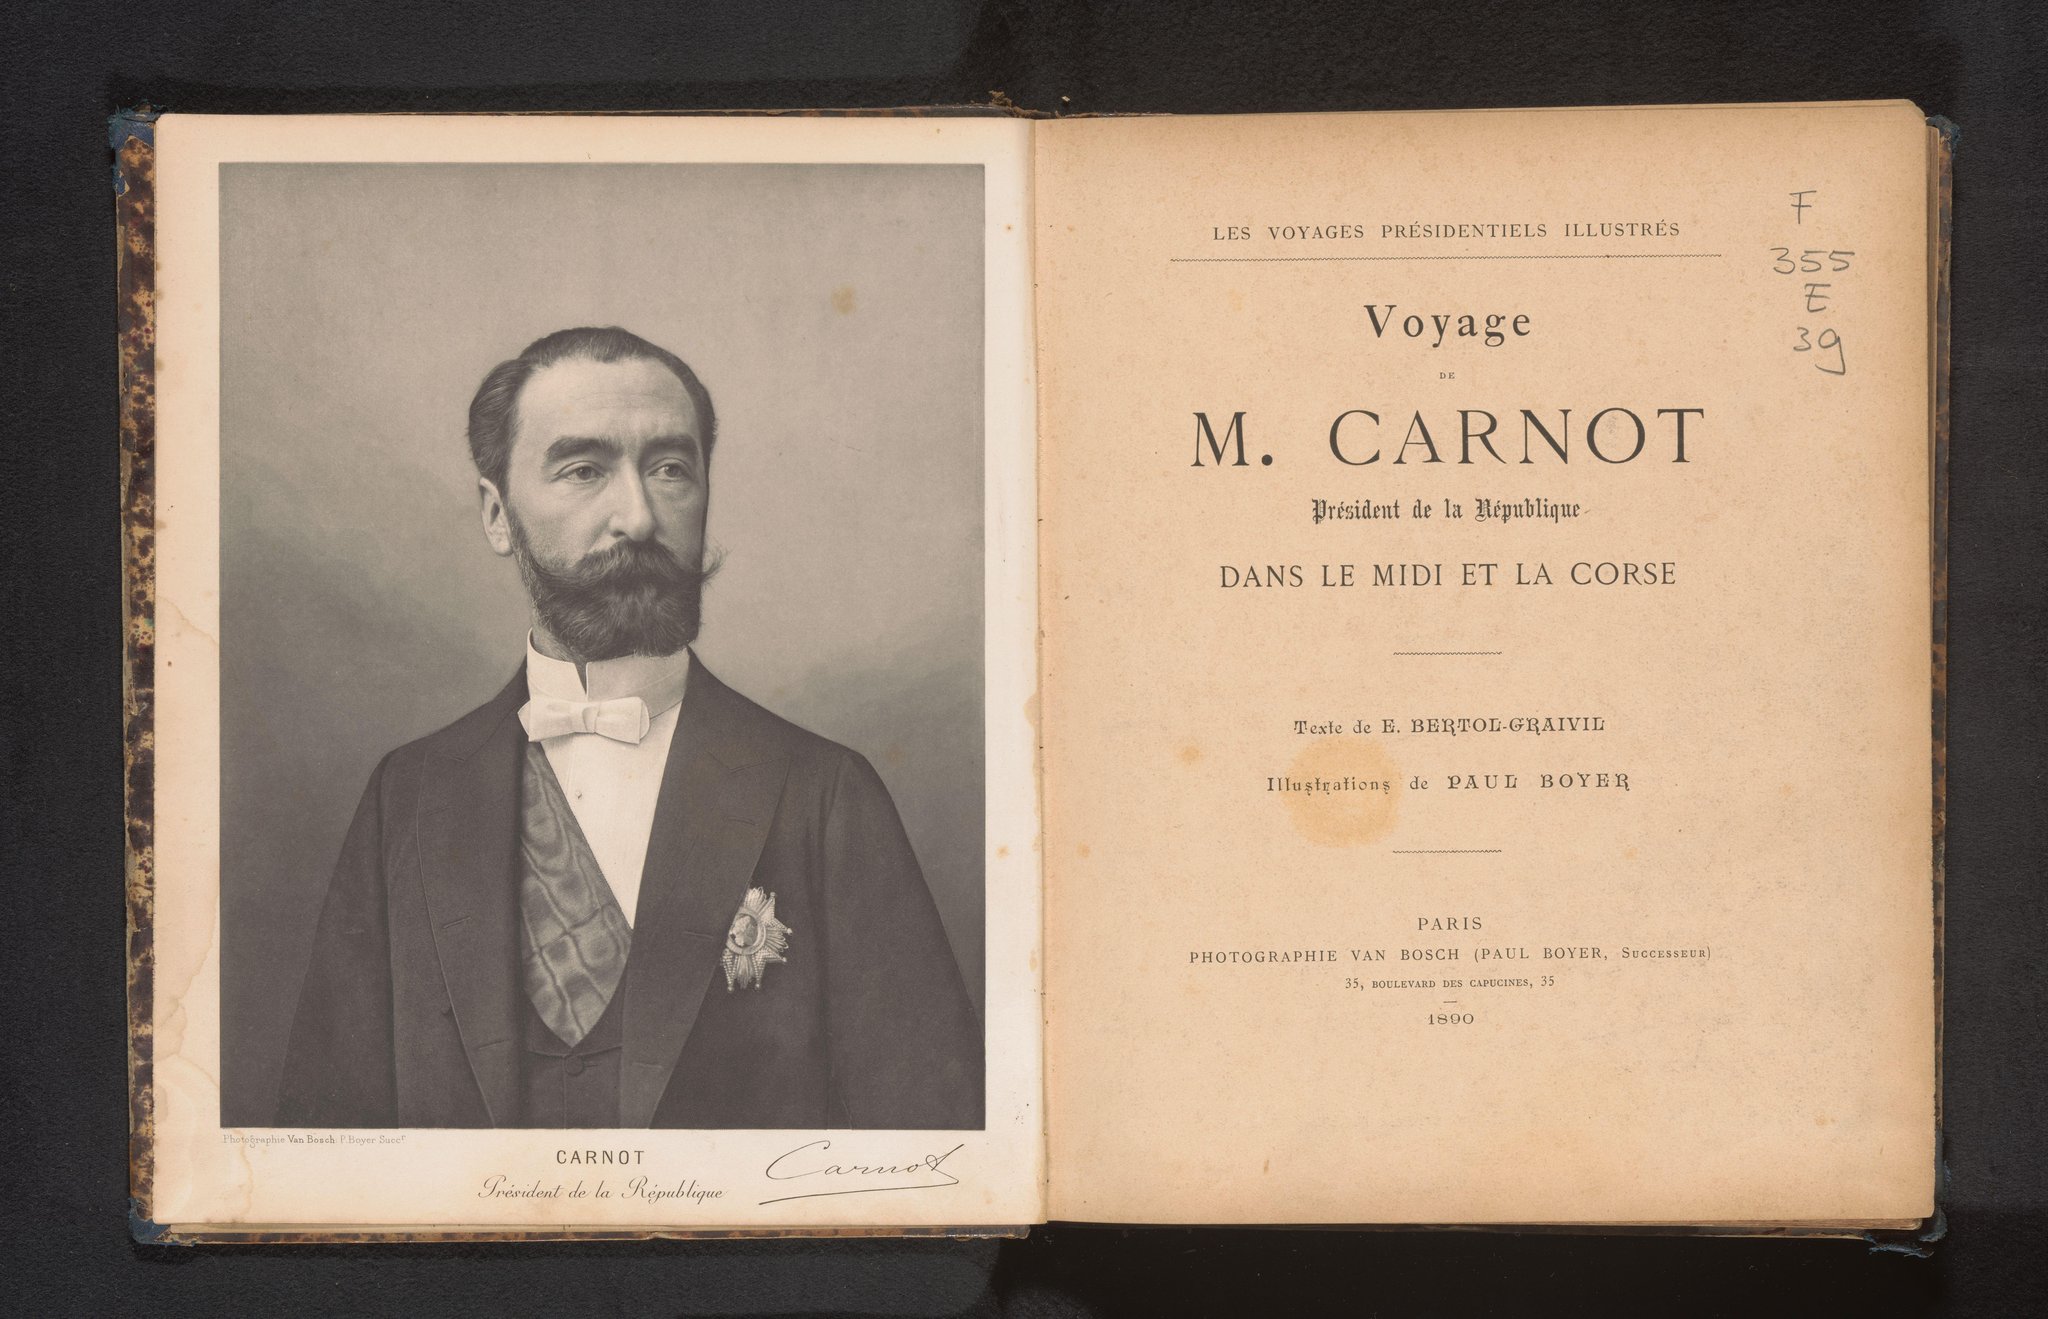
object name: photomechanical print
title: Portret van president Marie François Sadi Carnot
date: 1887-1890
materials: paper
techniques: photoaquatint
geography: france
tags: president ~ head of republic